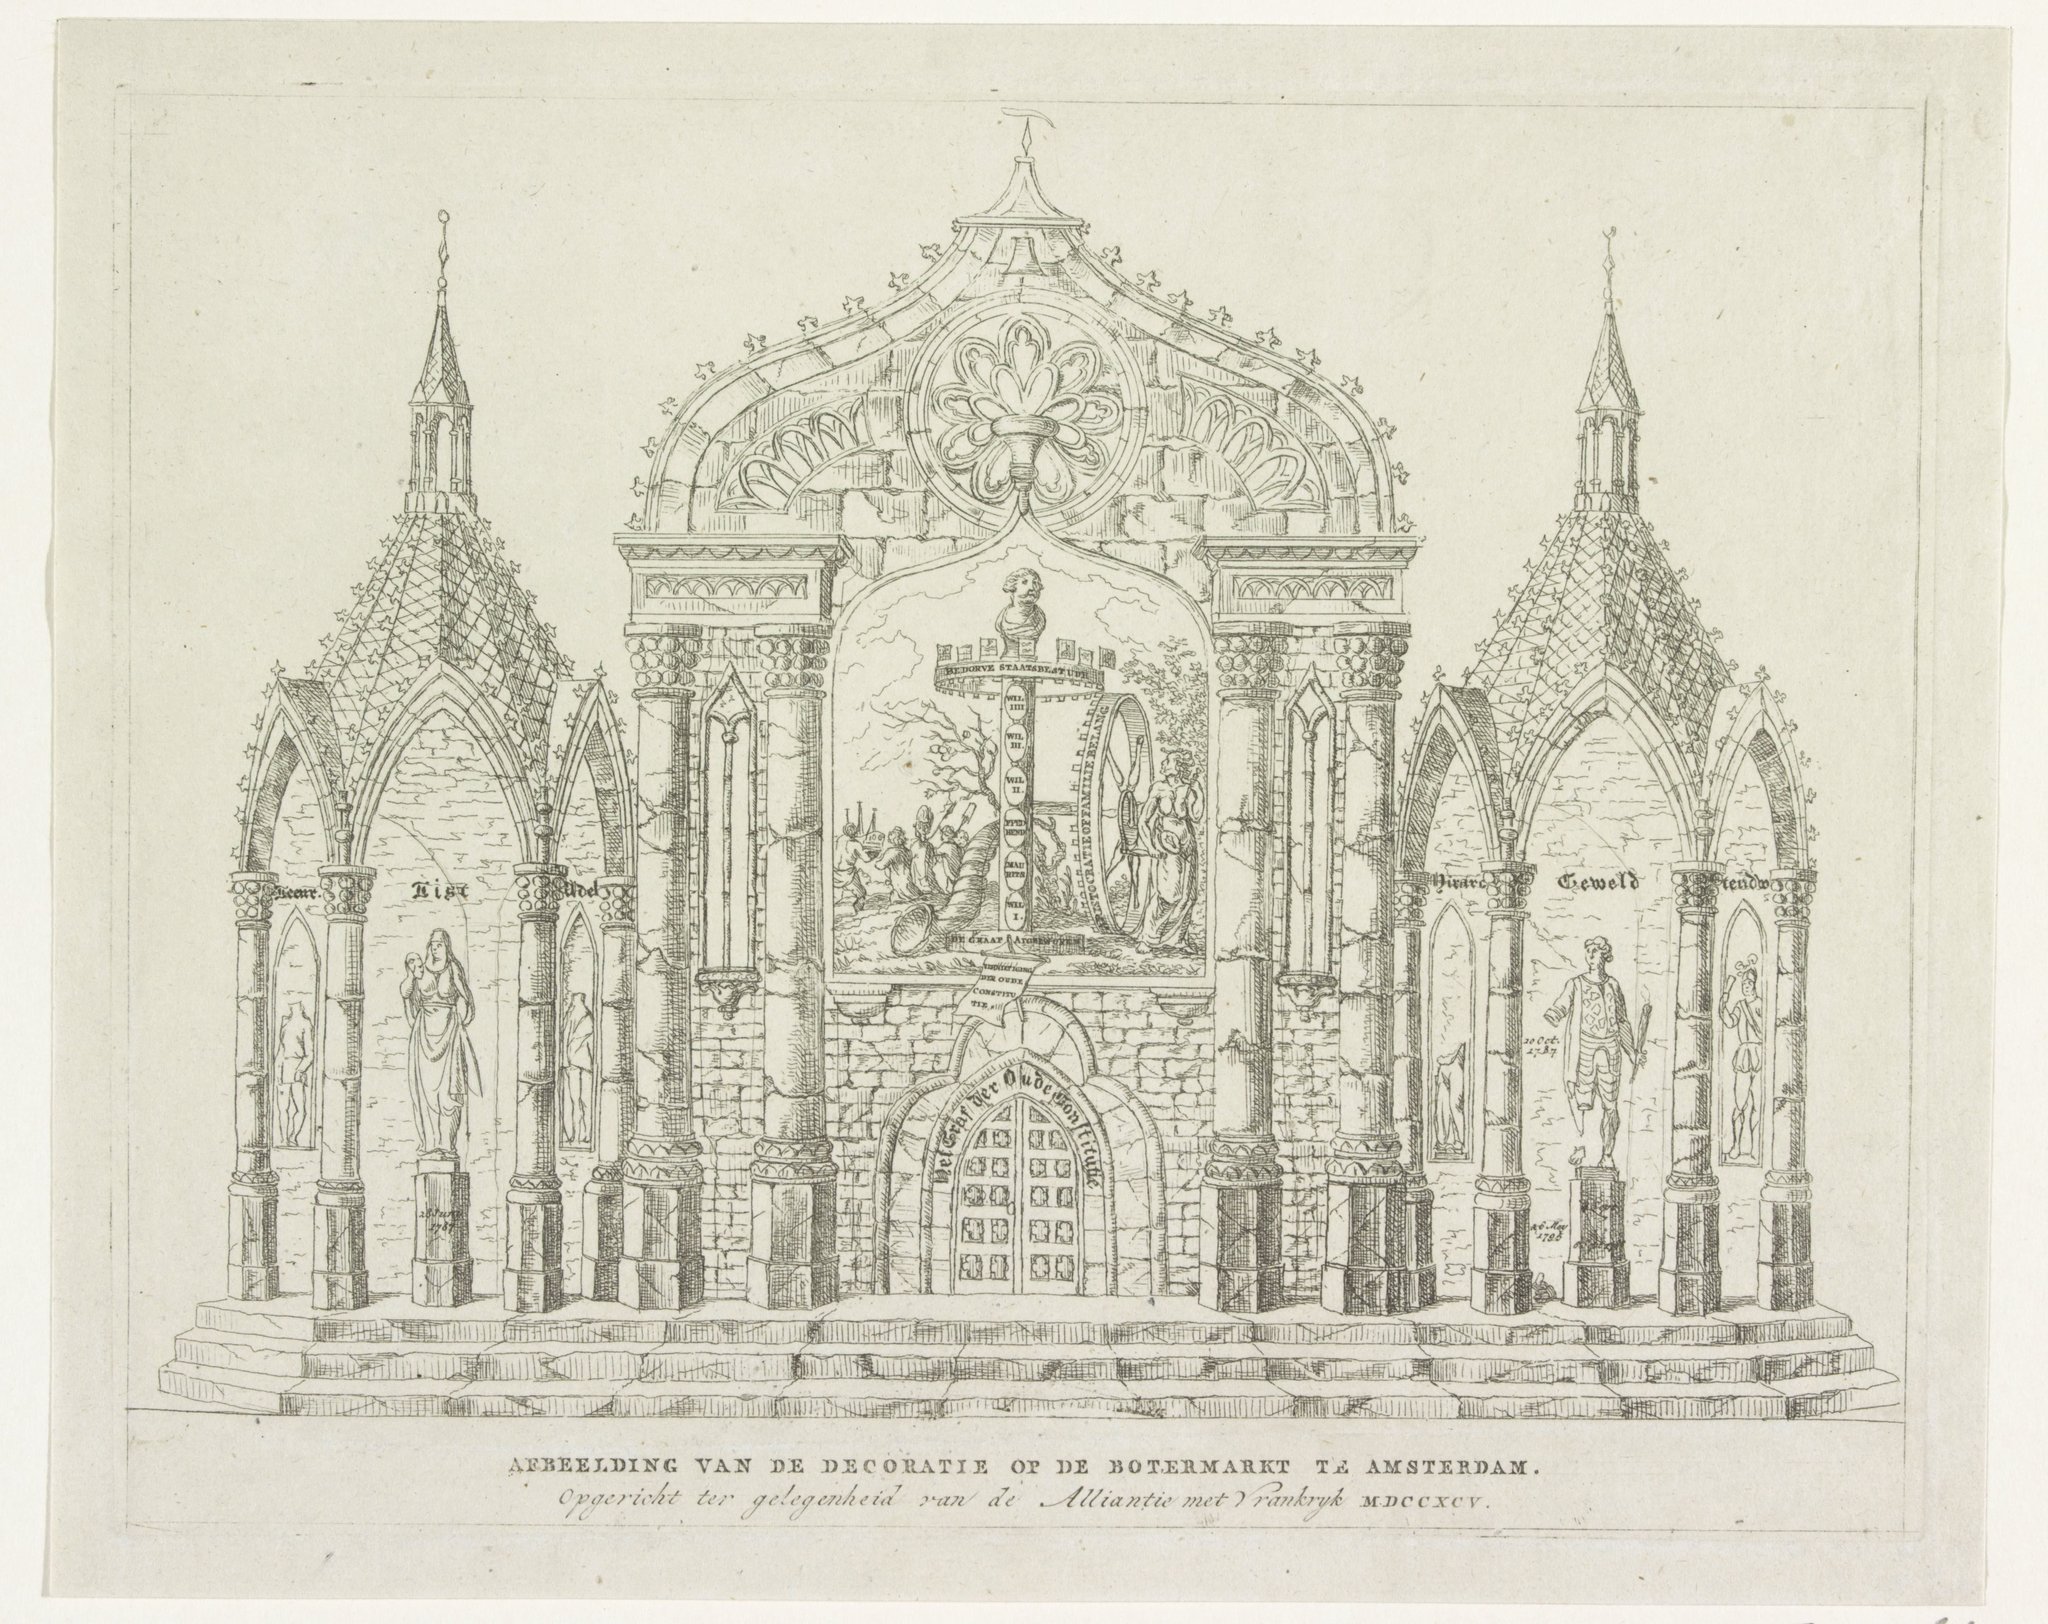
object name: print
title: Tien decoraties bij het Alliantiefeest te Amsterdam in 1795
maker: Anonymous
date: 1795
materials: paper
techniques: etching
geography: netherlands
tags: the old government and its supporters (after revolution), envy; 'invidia' (ripa) ~ personification of one of the seven deadly sins, ruin of church, monastery, etc., festivities on events of national importance (+ festive decoration ~ festive activities), amsterdam, alliance with france (1795)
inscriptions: collector's mark: Lugt 2228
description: De Vernietiging van de Oude Constitutie, allegorische decoratie opgericht op de Botermarkt te Amsterdam bij het Alliantiefeest op 19 juni 1795. Decoratie in de vorm van de ruïne van een gotische kapel, op het centrale chassinet draait de Nijd aan het rad van de aristocratie dat een molensteen in beweging brengt. Onderdeel van een serie van tien platen.